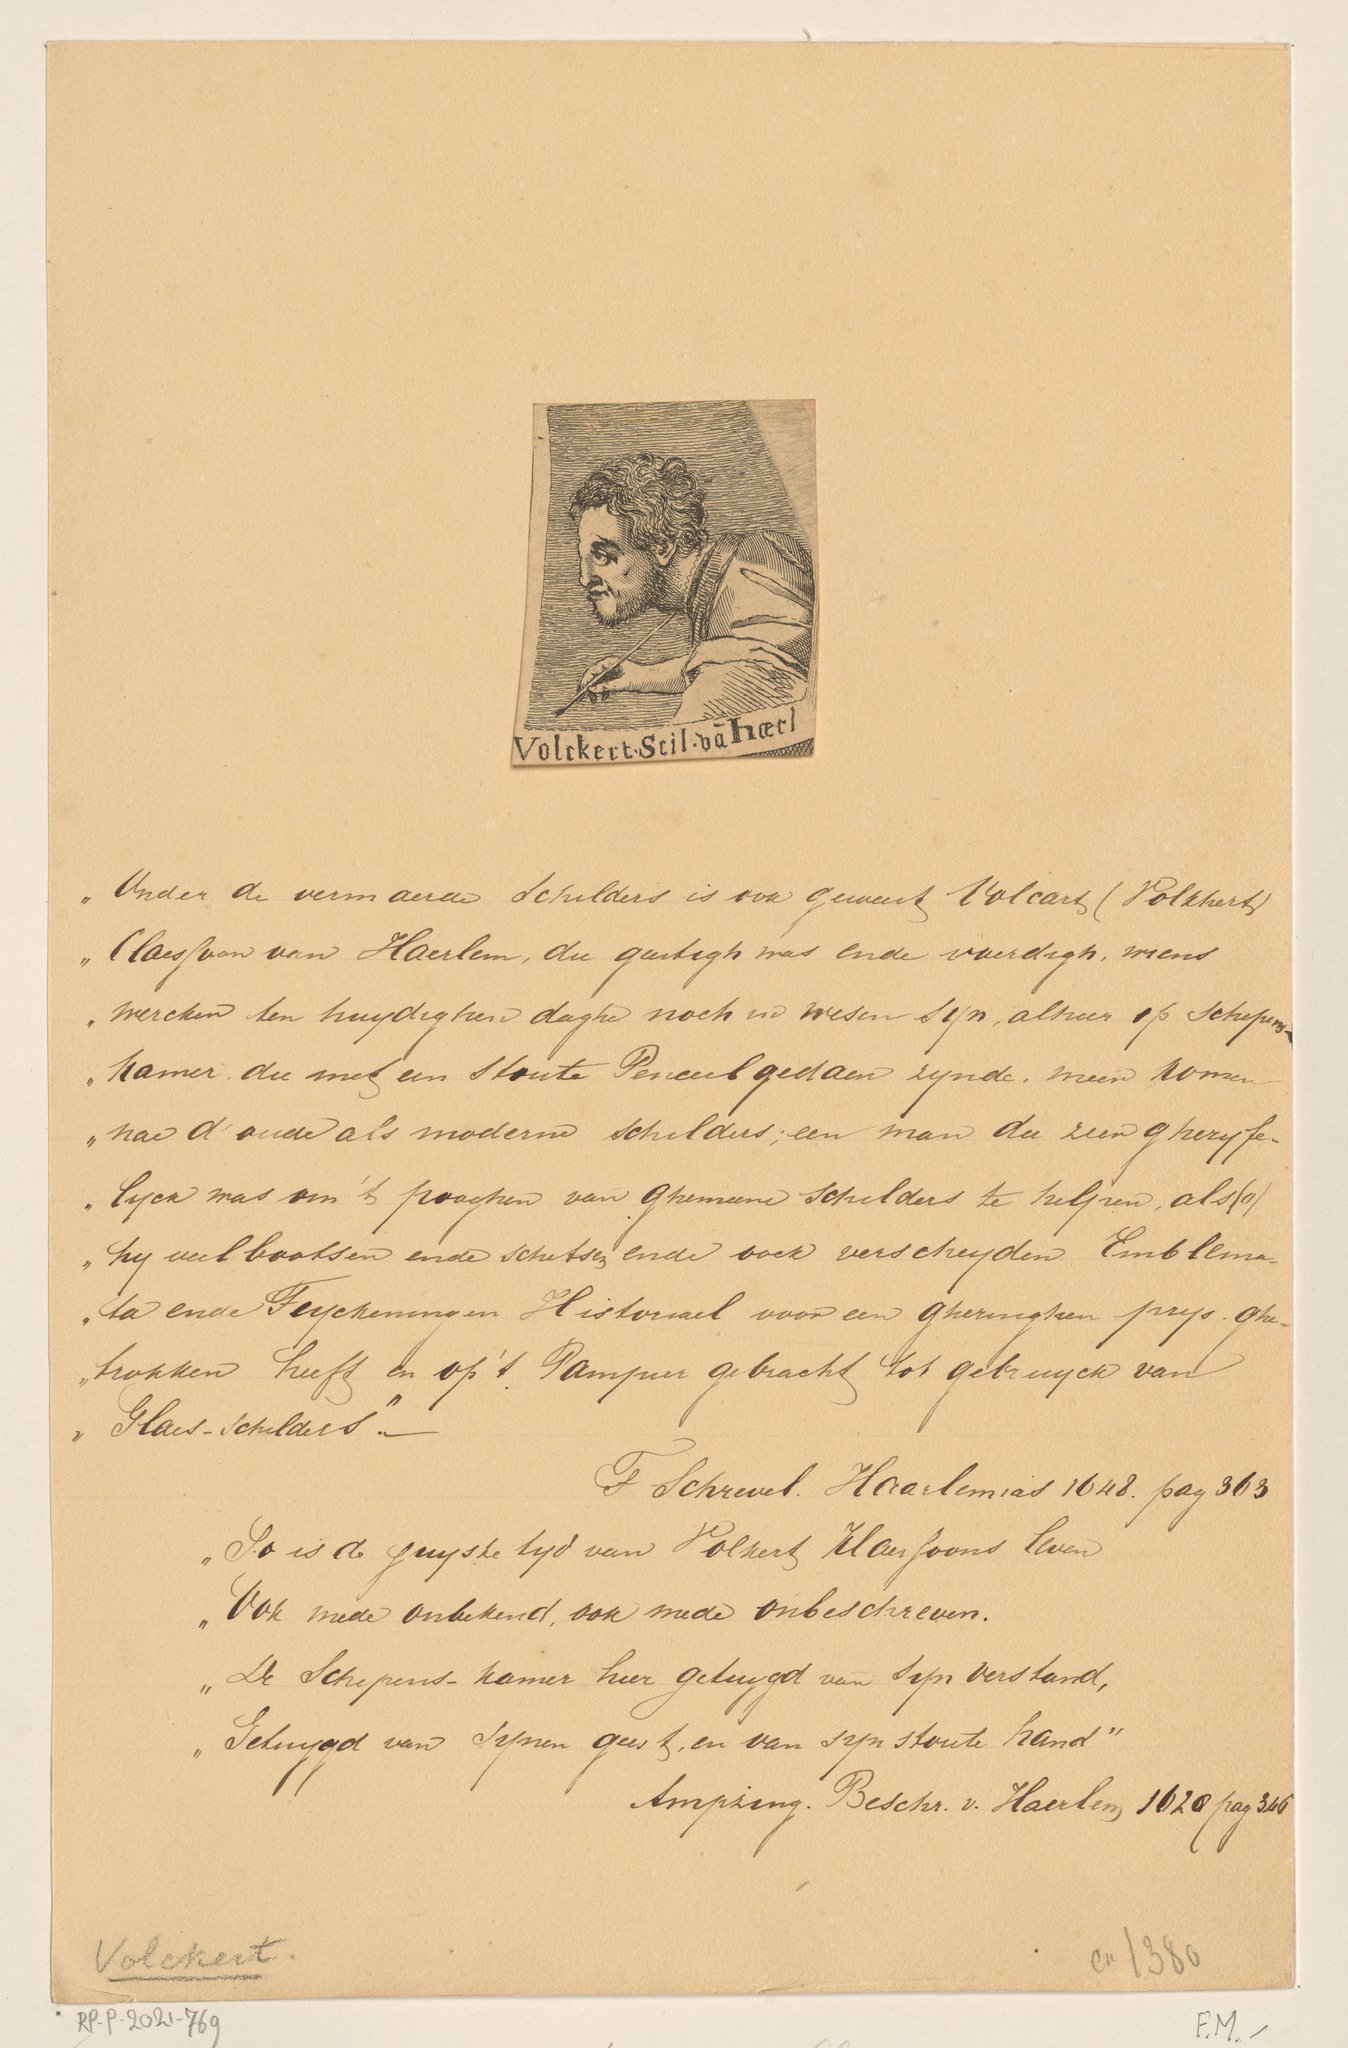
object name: print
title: Portret van Volckert Claesz.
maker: jan l admiral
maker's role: draughtsman, print maker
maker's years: 1699-1773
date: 1764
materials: paper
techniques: etching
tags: painter, designer, historical persons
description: Prent waarschijnlijk uit: Mander, Karel van. Het leven der doorluchtige Nederlandsche en eenige Hoogduitsche schilders (...). Amsterdam: Steven van Esveldt, 1764, dl. 1.